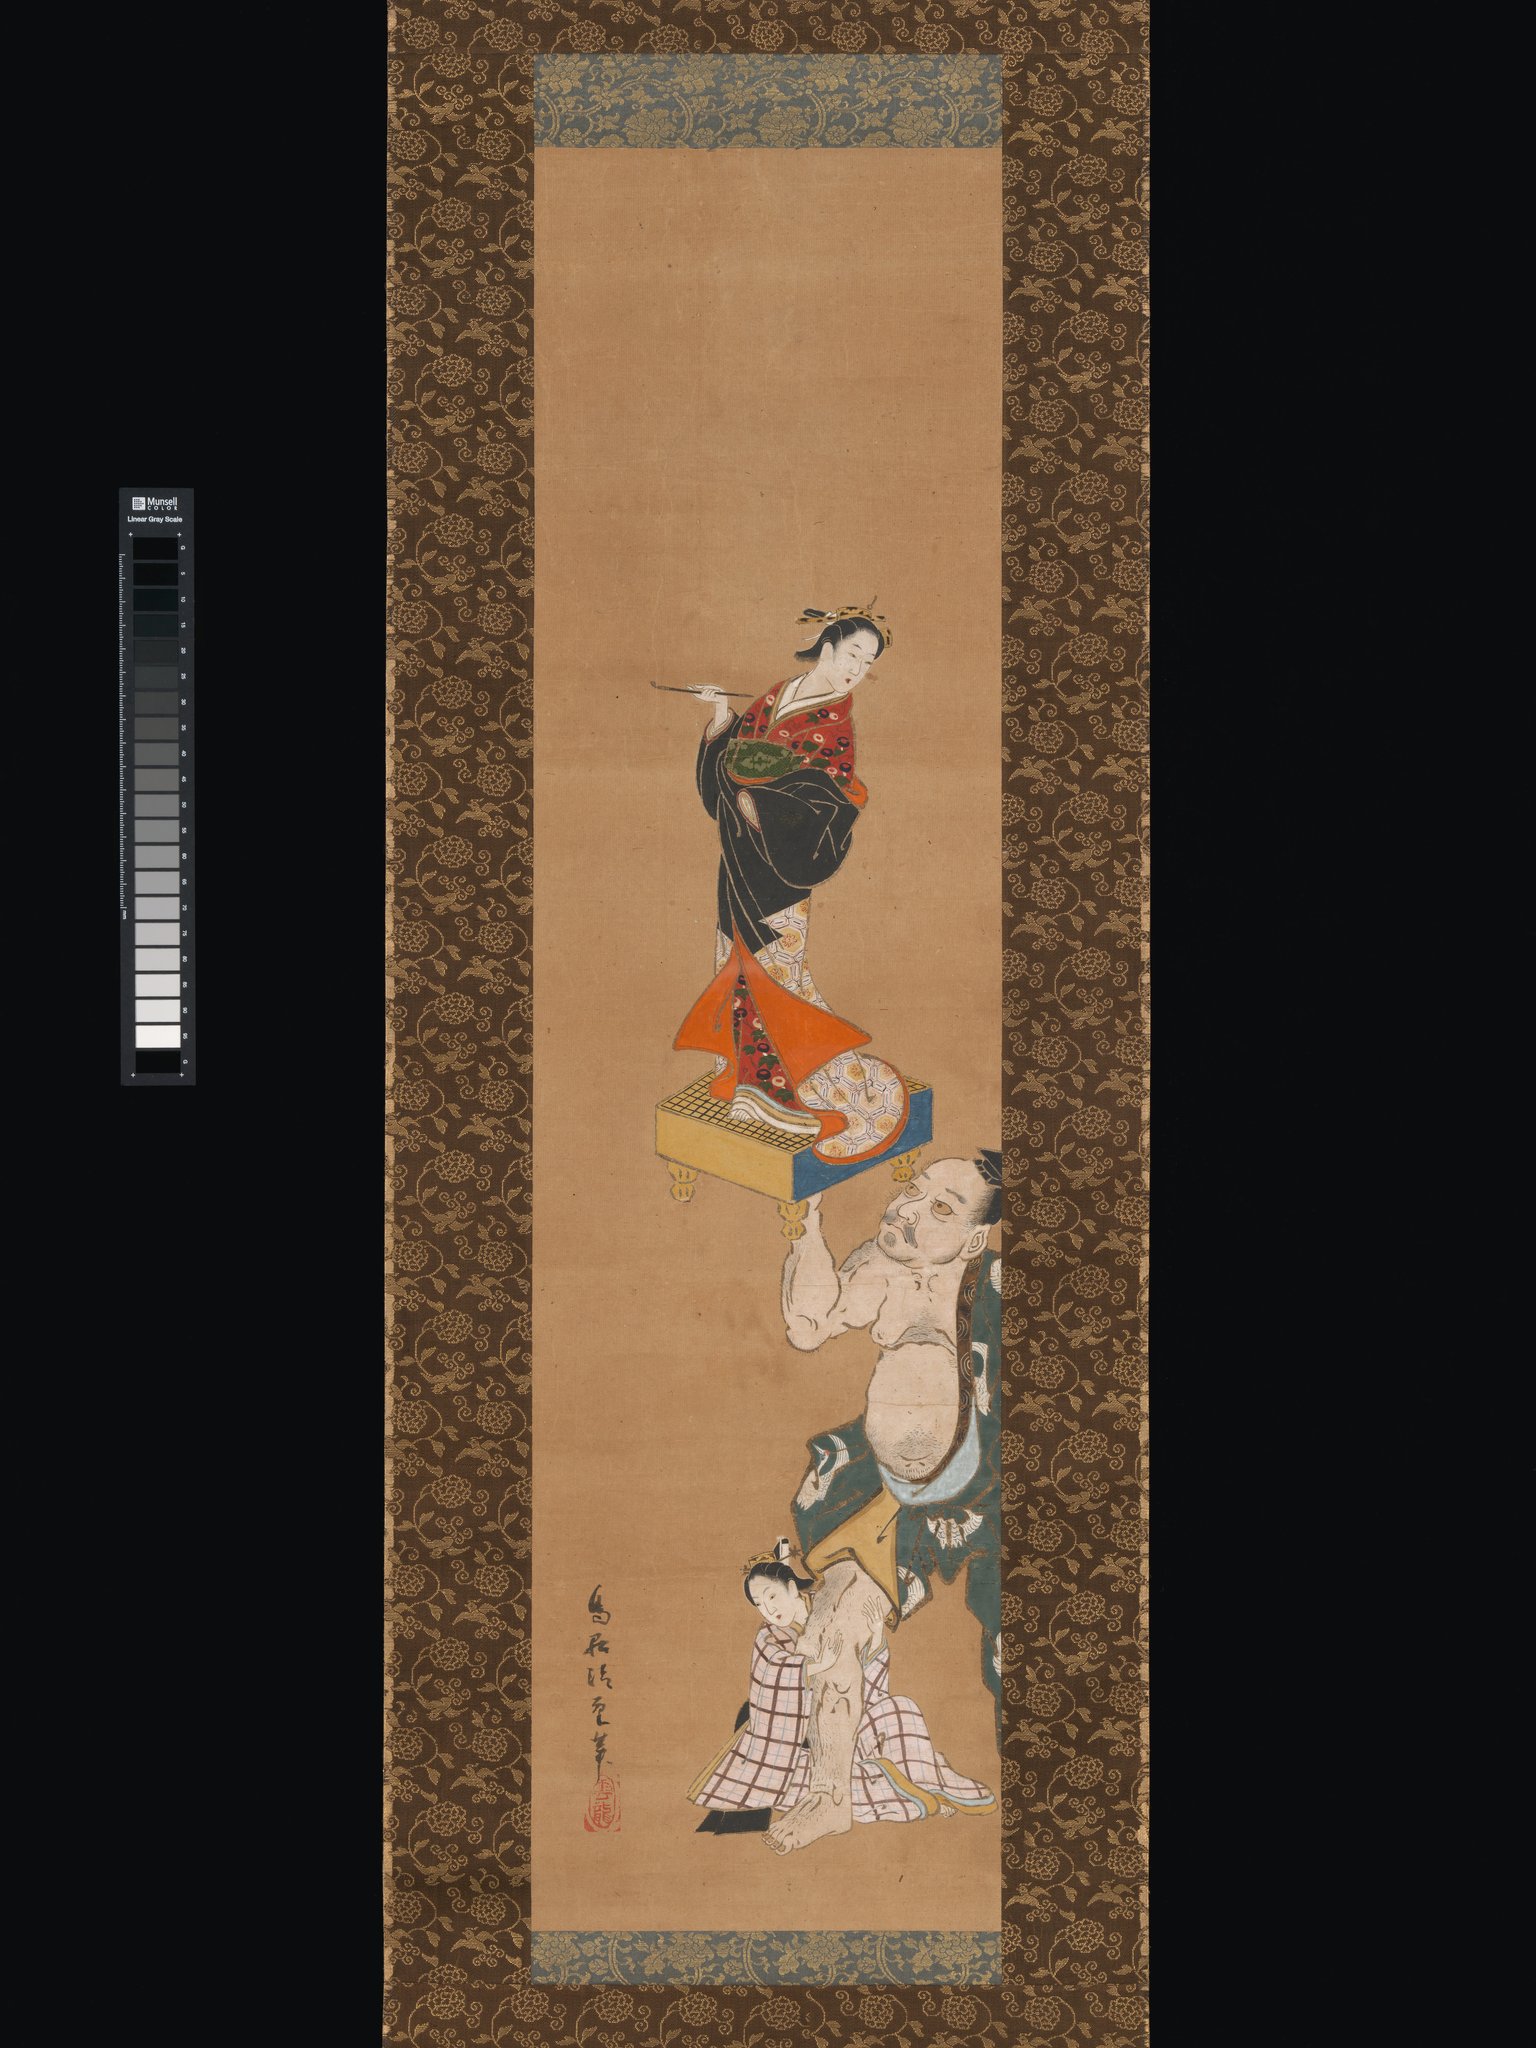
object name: hanging scroll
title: The Warrior Asahina Yoshihide Lifting a Puppet of a Courtesan on a Go Board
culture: japanese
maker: torii kiyoshige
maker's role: artist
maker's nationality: japanese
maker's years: 1716-1759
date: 1734-1766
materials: gold, ink, paper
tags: men,women,puppets